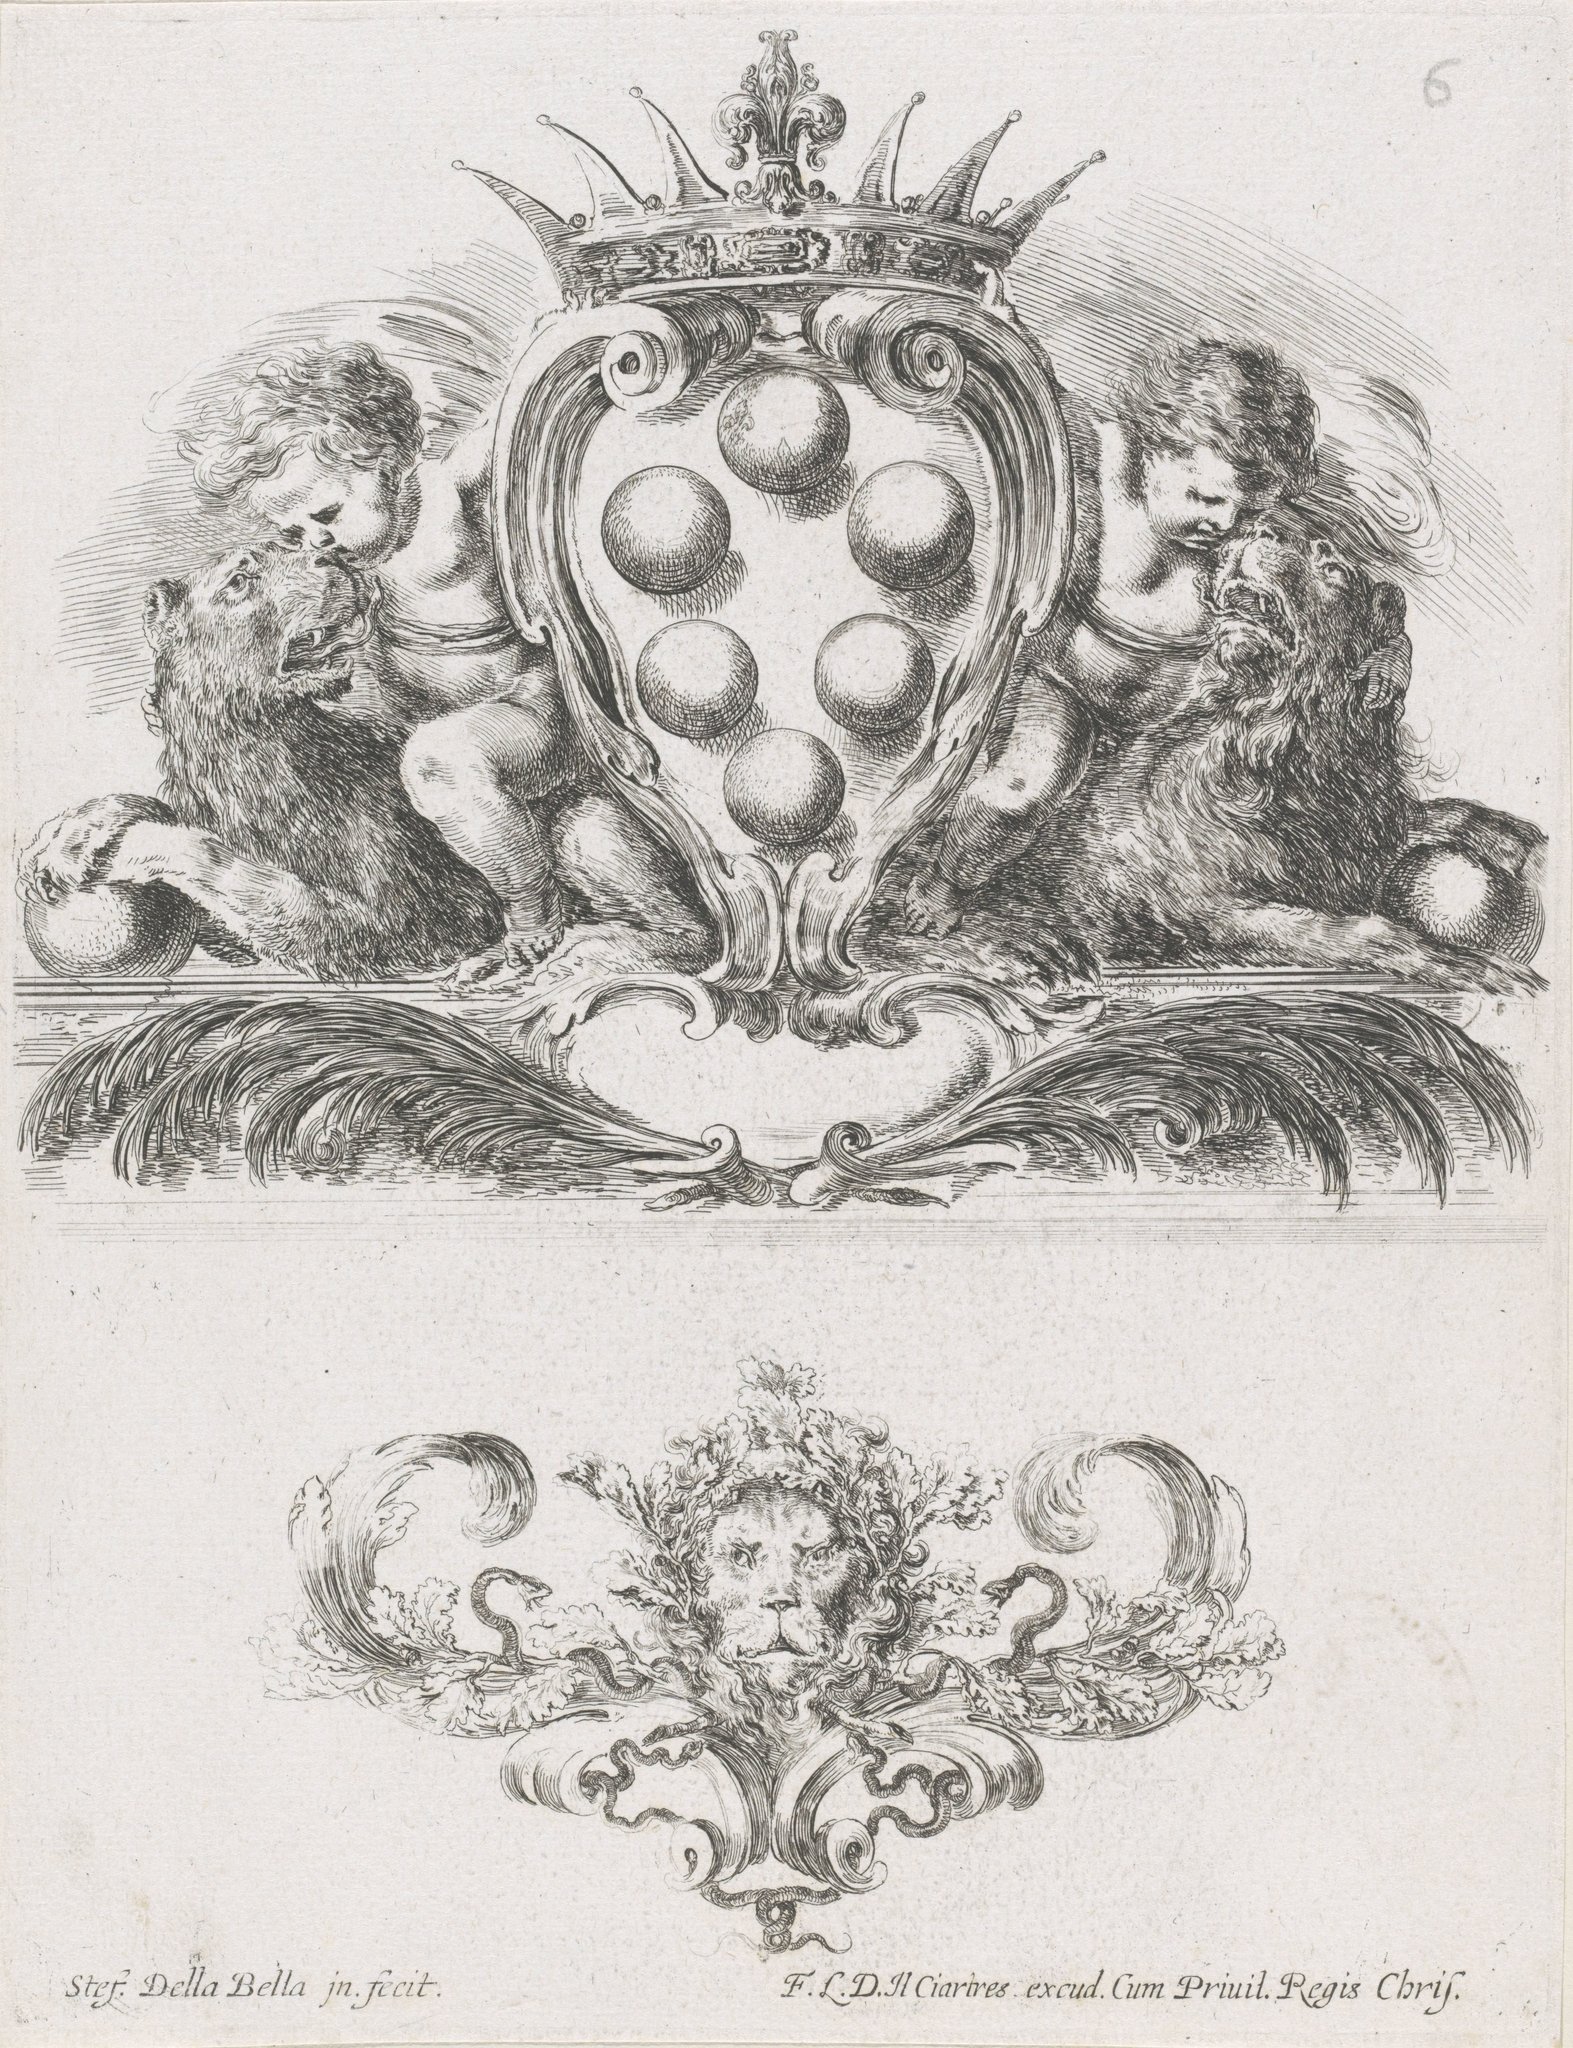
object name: ornament print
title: Cartouches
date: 1646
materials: paper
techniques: etching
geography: france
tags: coat of arms (as symbol of the state, etc.), lion's head ~ ornament, snakes, ornament ~ cartouche, cupids: 'amores', 'amoretti', 'putti'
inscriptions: collector's mark: Lugt 240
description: Boven een cartouche met het wapen van de familie De' Medici, aan weerszijden geflankeerd door een putto op de rug van een leeuw. Onder een vignet met een leeuwenkop, eikenbladeren en twee slangen.